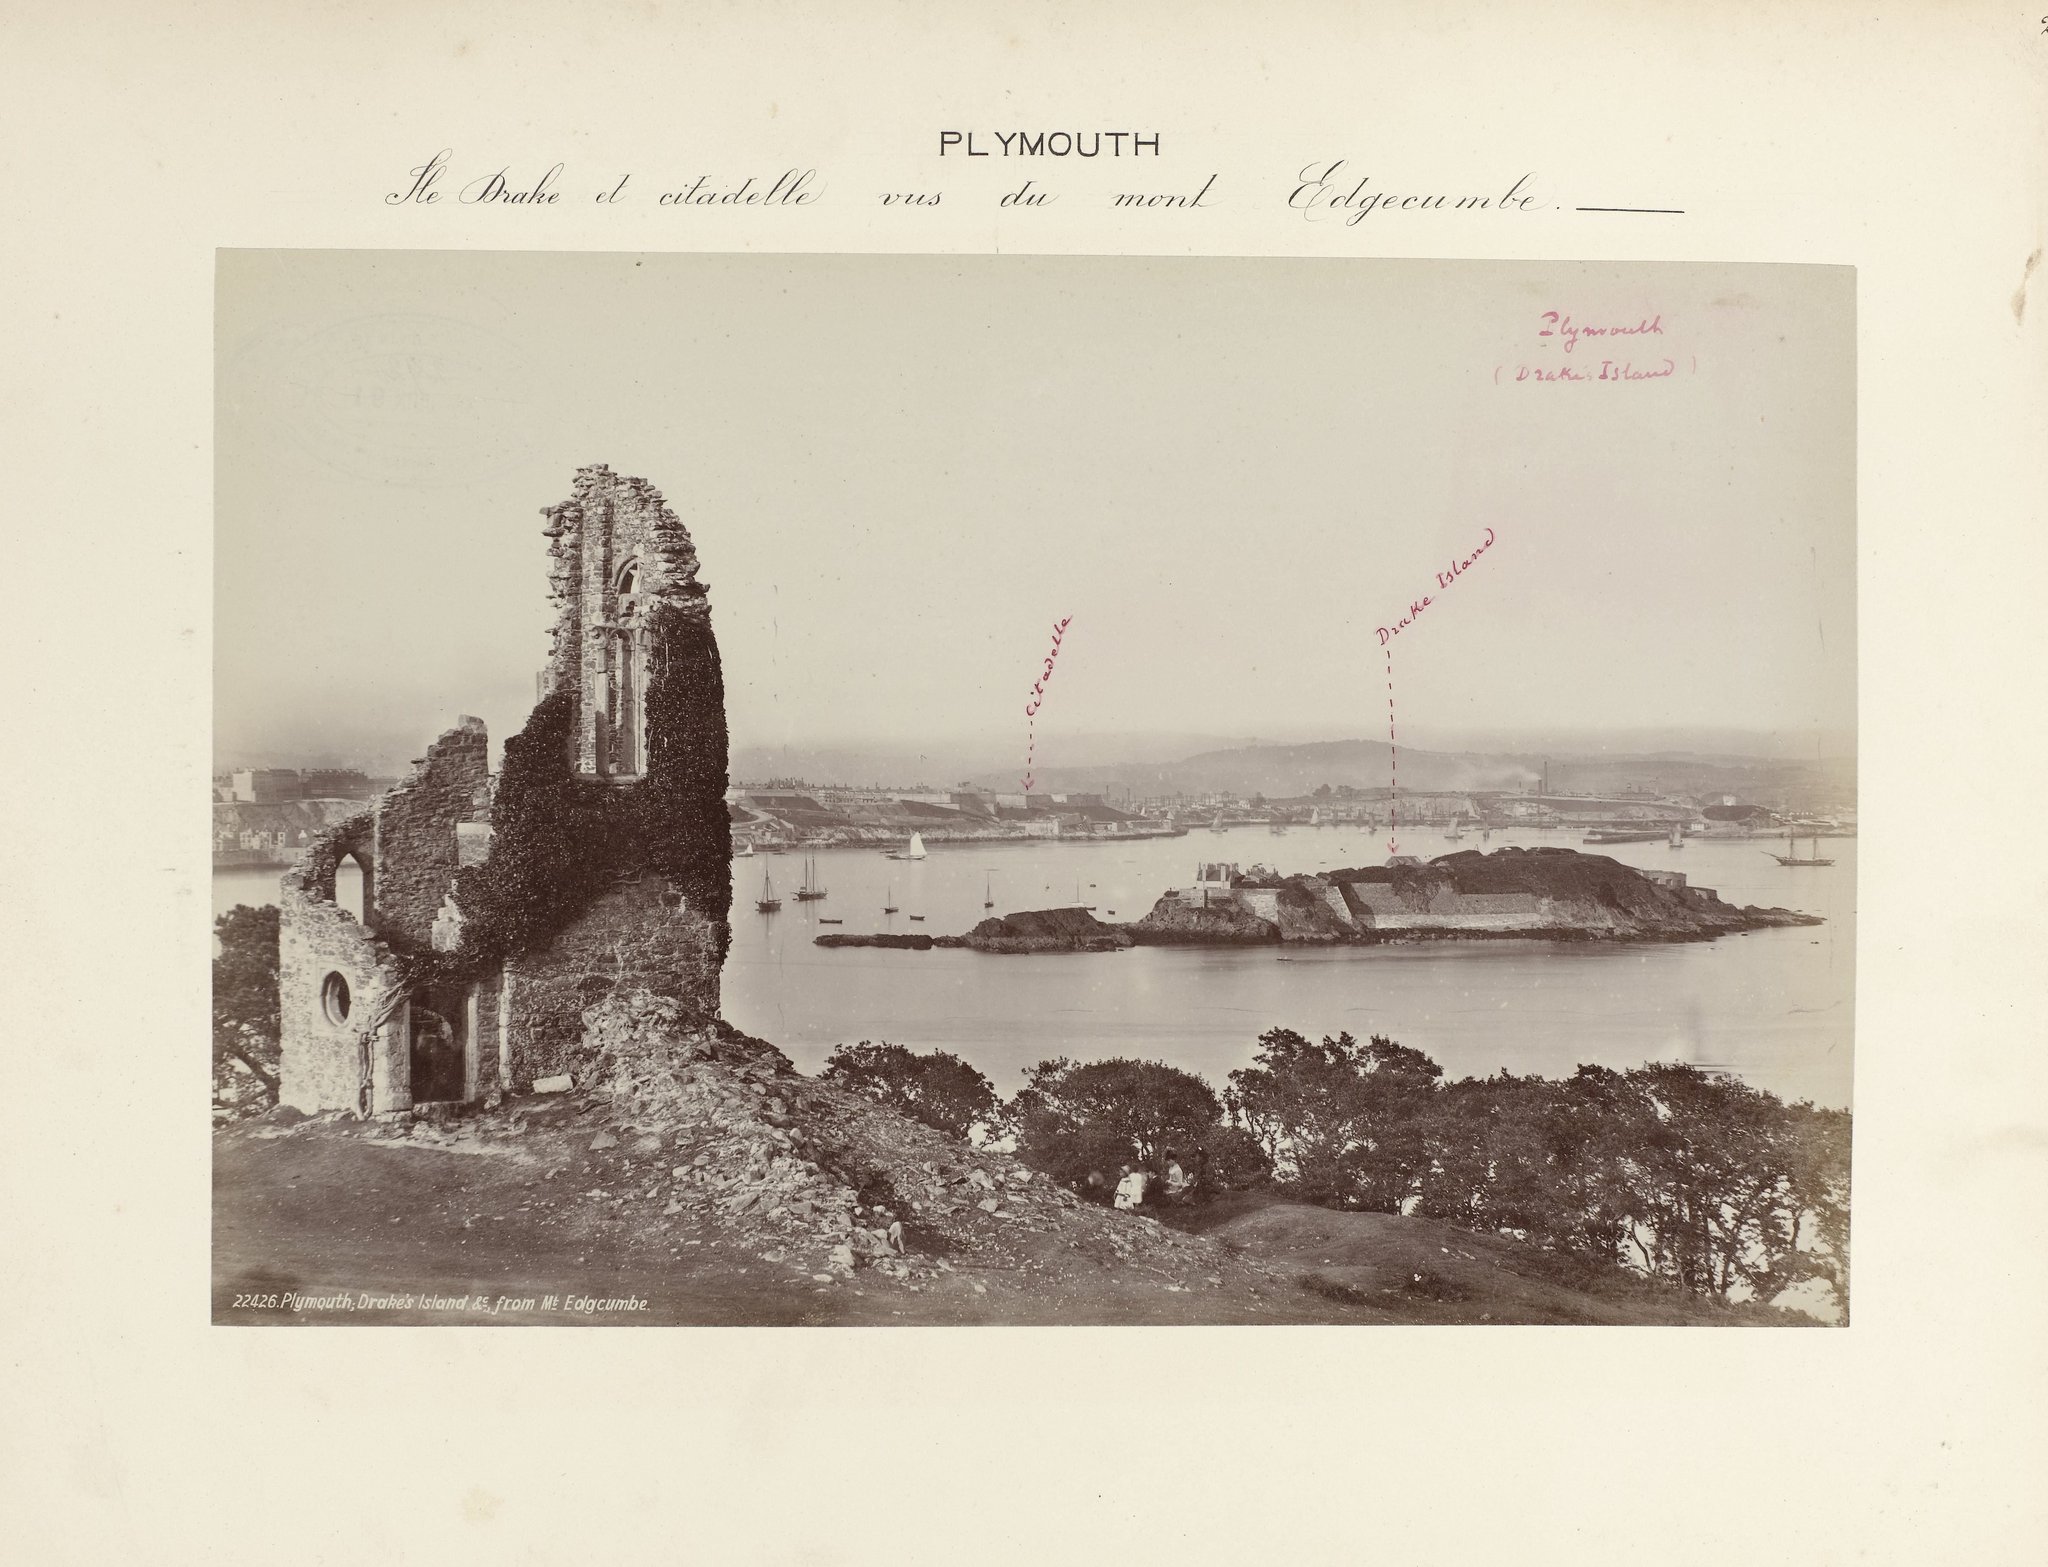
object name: photograph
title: Gezicht op Plymouth vanaf Mount Edgcumbe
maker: Anonymous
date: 1891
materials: cardboard, paper, photographic support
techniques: albumen print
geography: great britain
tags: plymouth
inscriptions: inscription: ‘22426. Plymouth; Drake's Island &c, from Mt Edgcumbe.’, inscription: ‘PLYMOUTH / Ile Drake et citadelle vus du mont Edgecumbe. -’, inscription: ‘Citadelle // Drake Island // Plymouth / (Drake's Island)’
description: Foto uit een album met 35 topografische foto's van Britse kustplaatsen, waarop in pen militaire verdedigingswerken zijn aangegeven door een Franse militair.